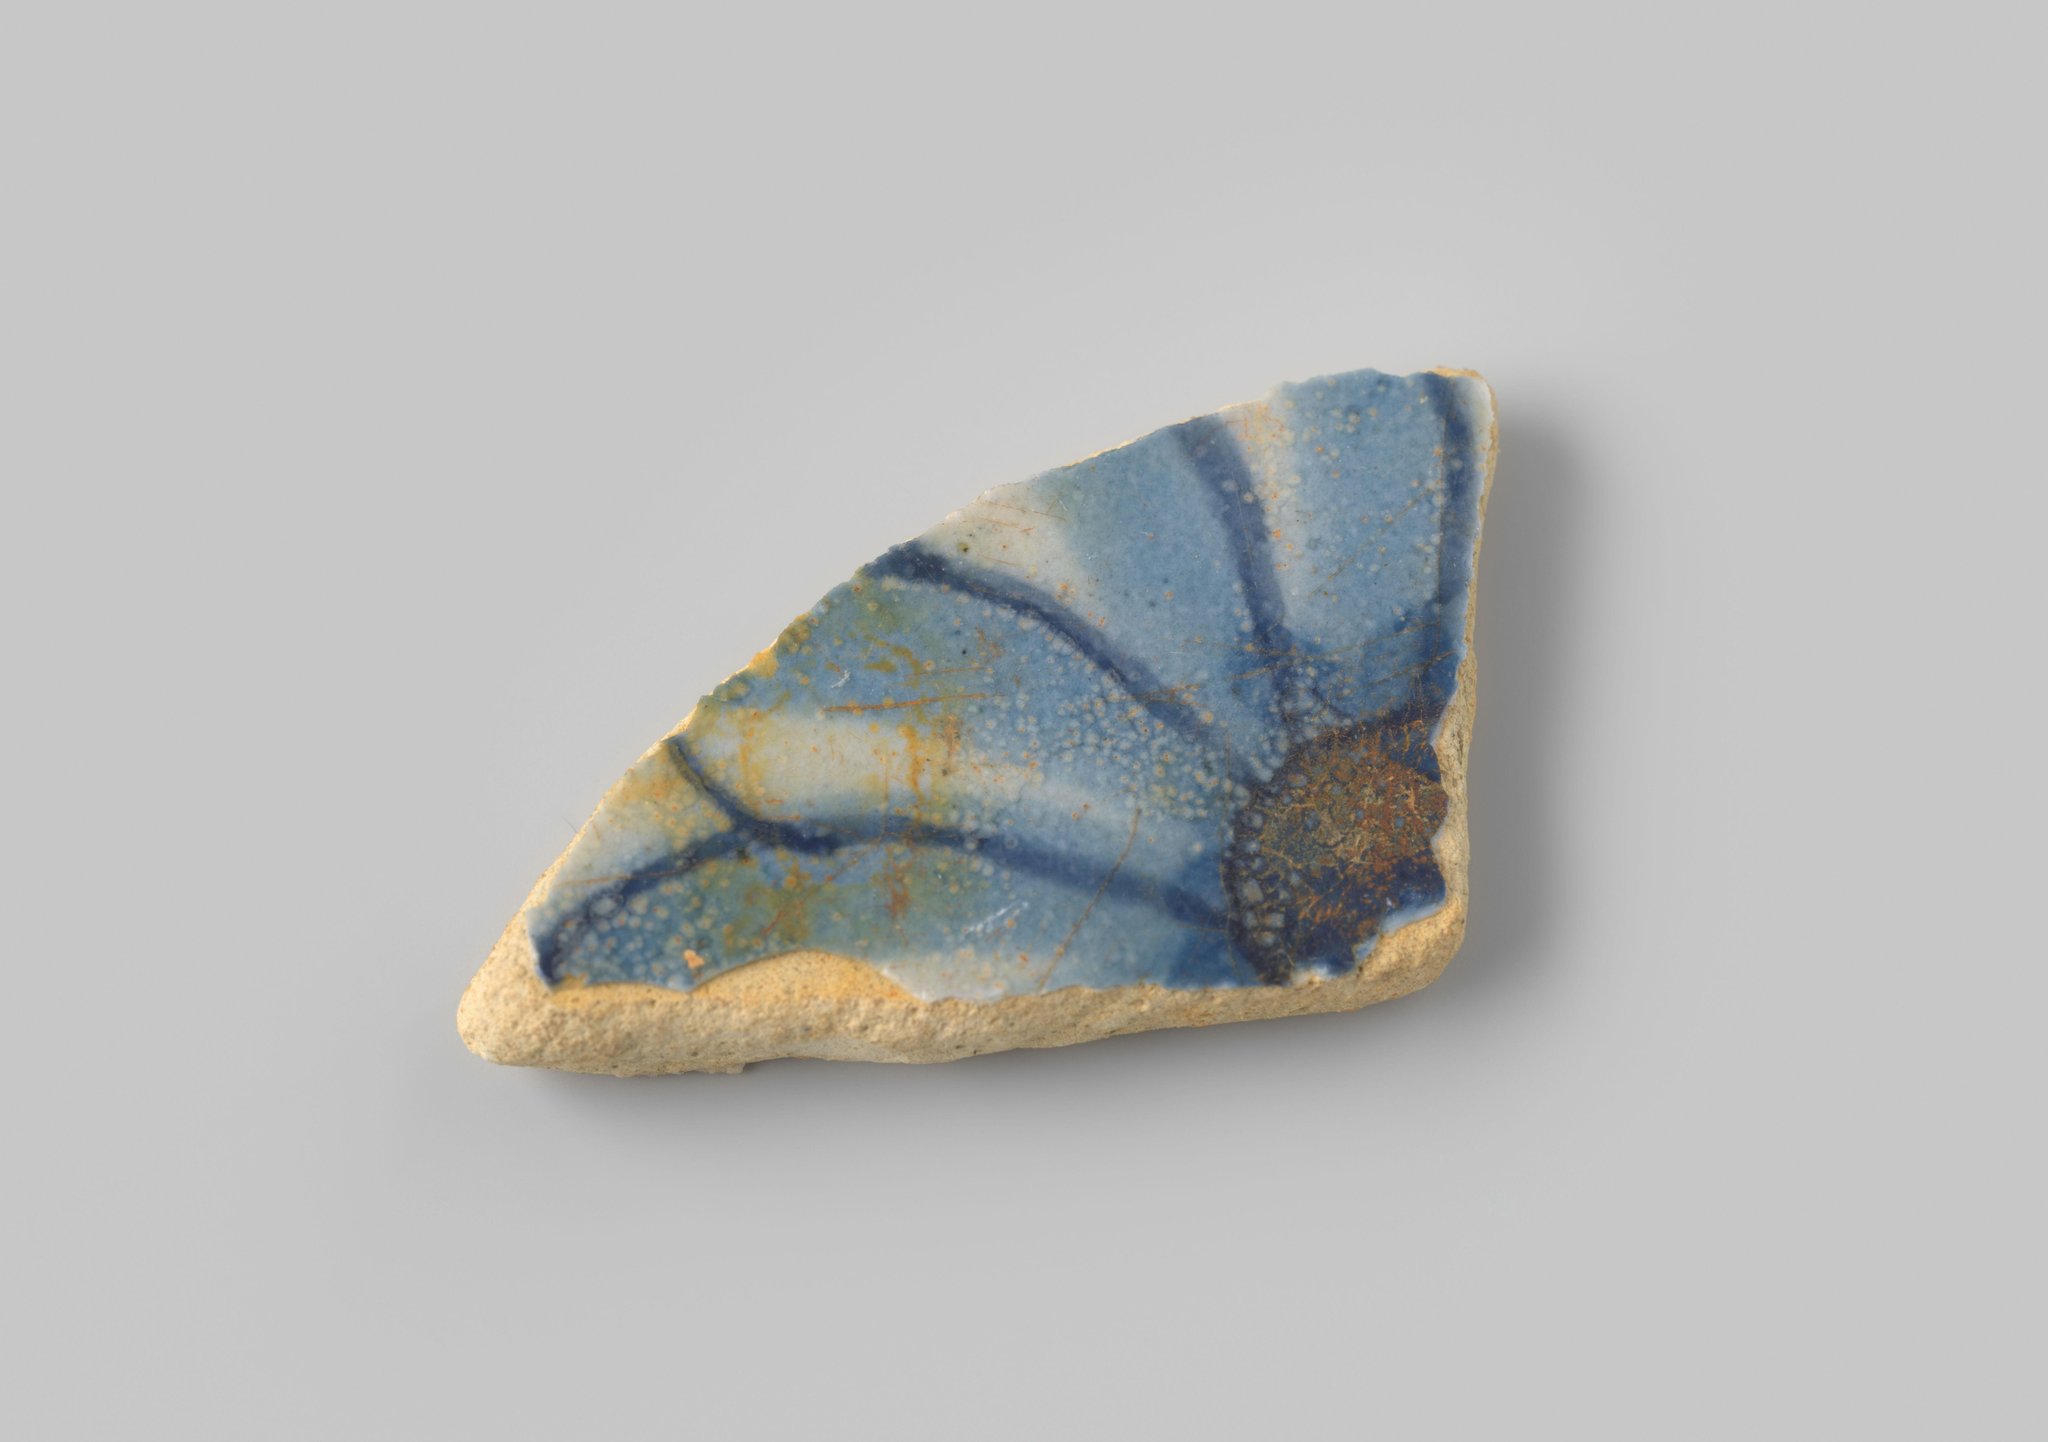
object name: plate dish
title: Scherf van een bord uit het wrak van de Oost-Indiëvaarder Hollandia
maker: Anonymous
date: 1700-1743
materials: faience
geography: netherlands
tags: verenigde oostindische compagnie, hollandia (schip), annet